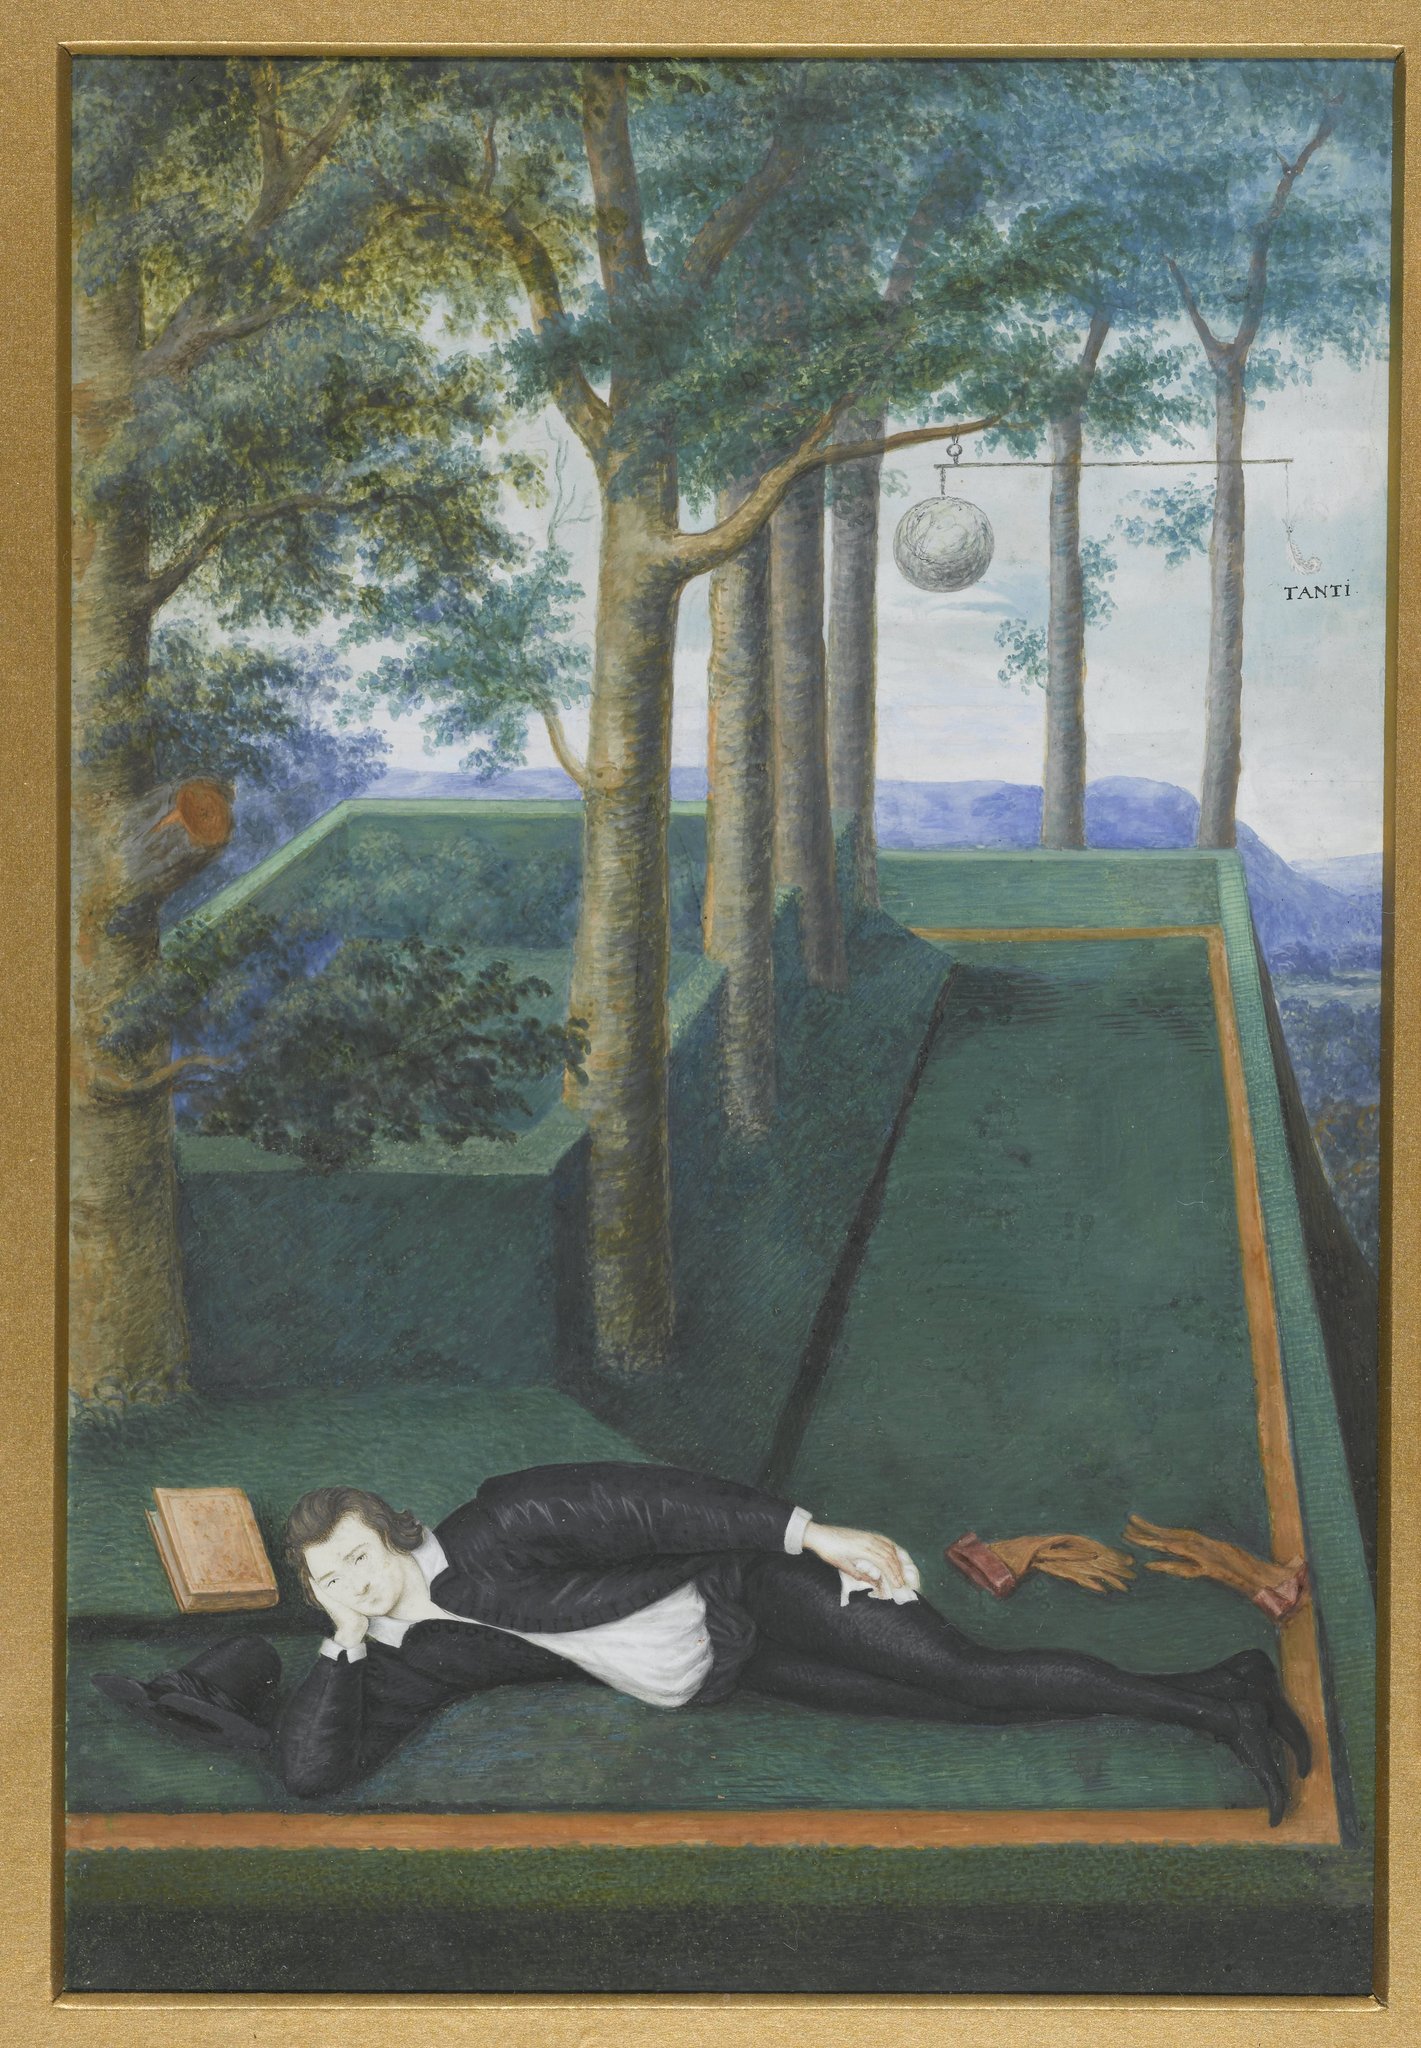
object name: drawing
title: Portret van een liggende edelman in een begroeide hof; Portret van Henry Percy, 9th Earl of Northumberland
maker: nicholas hilliard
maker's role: draughtsman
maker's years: 1547-1619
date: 1590-1595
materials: parchment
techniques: brush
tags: garden, historical persons, lying figure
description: 'The Wizard Earl'(1564-1632) is gekleed in zwart, de kleur van de magiërs, en steunt eht hoofd in diepzinnig nadenken. Er zijn twee omheinde tuinen en in de boom hangt een symbolisch teken. De grote rechthoekige tuin staat voor Wetenschap, de kleine voor Filosofie. Aan de boom hangt een bol in evenwicht met een veertje, op ongelijke afstand van elkaar. Deze vormen een rebus: het woord'sphere'(bol) wordt geassocieerd met 'espoir'(hoop) en 'penne'(veer) met 'peine' (verdriet).